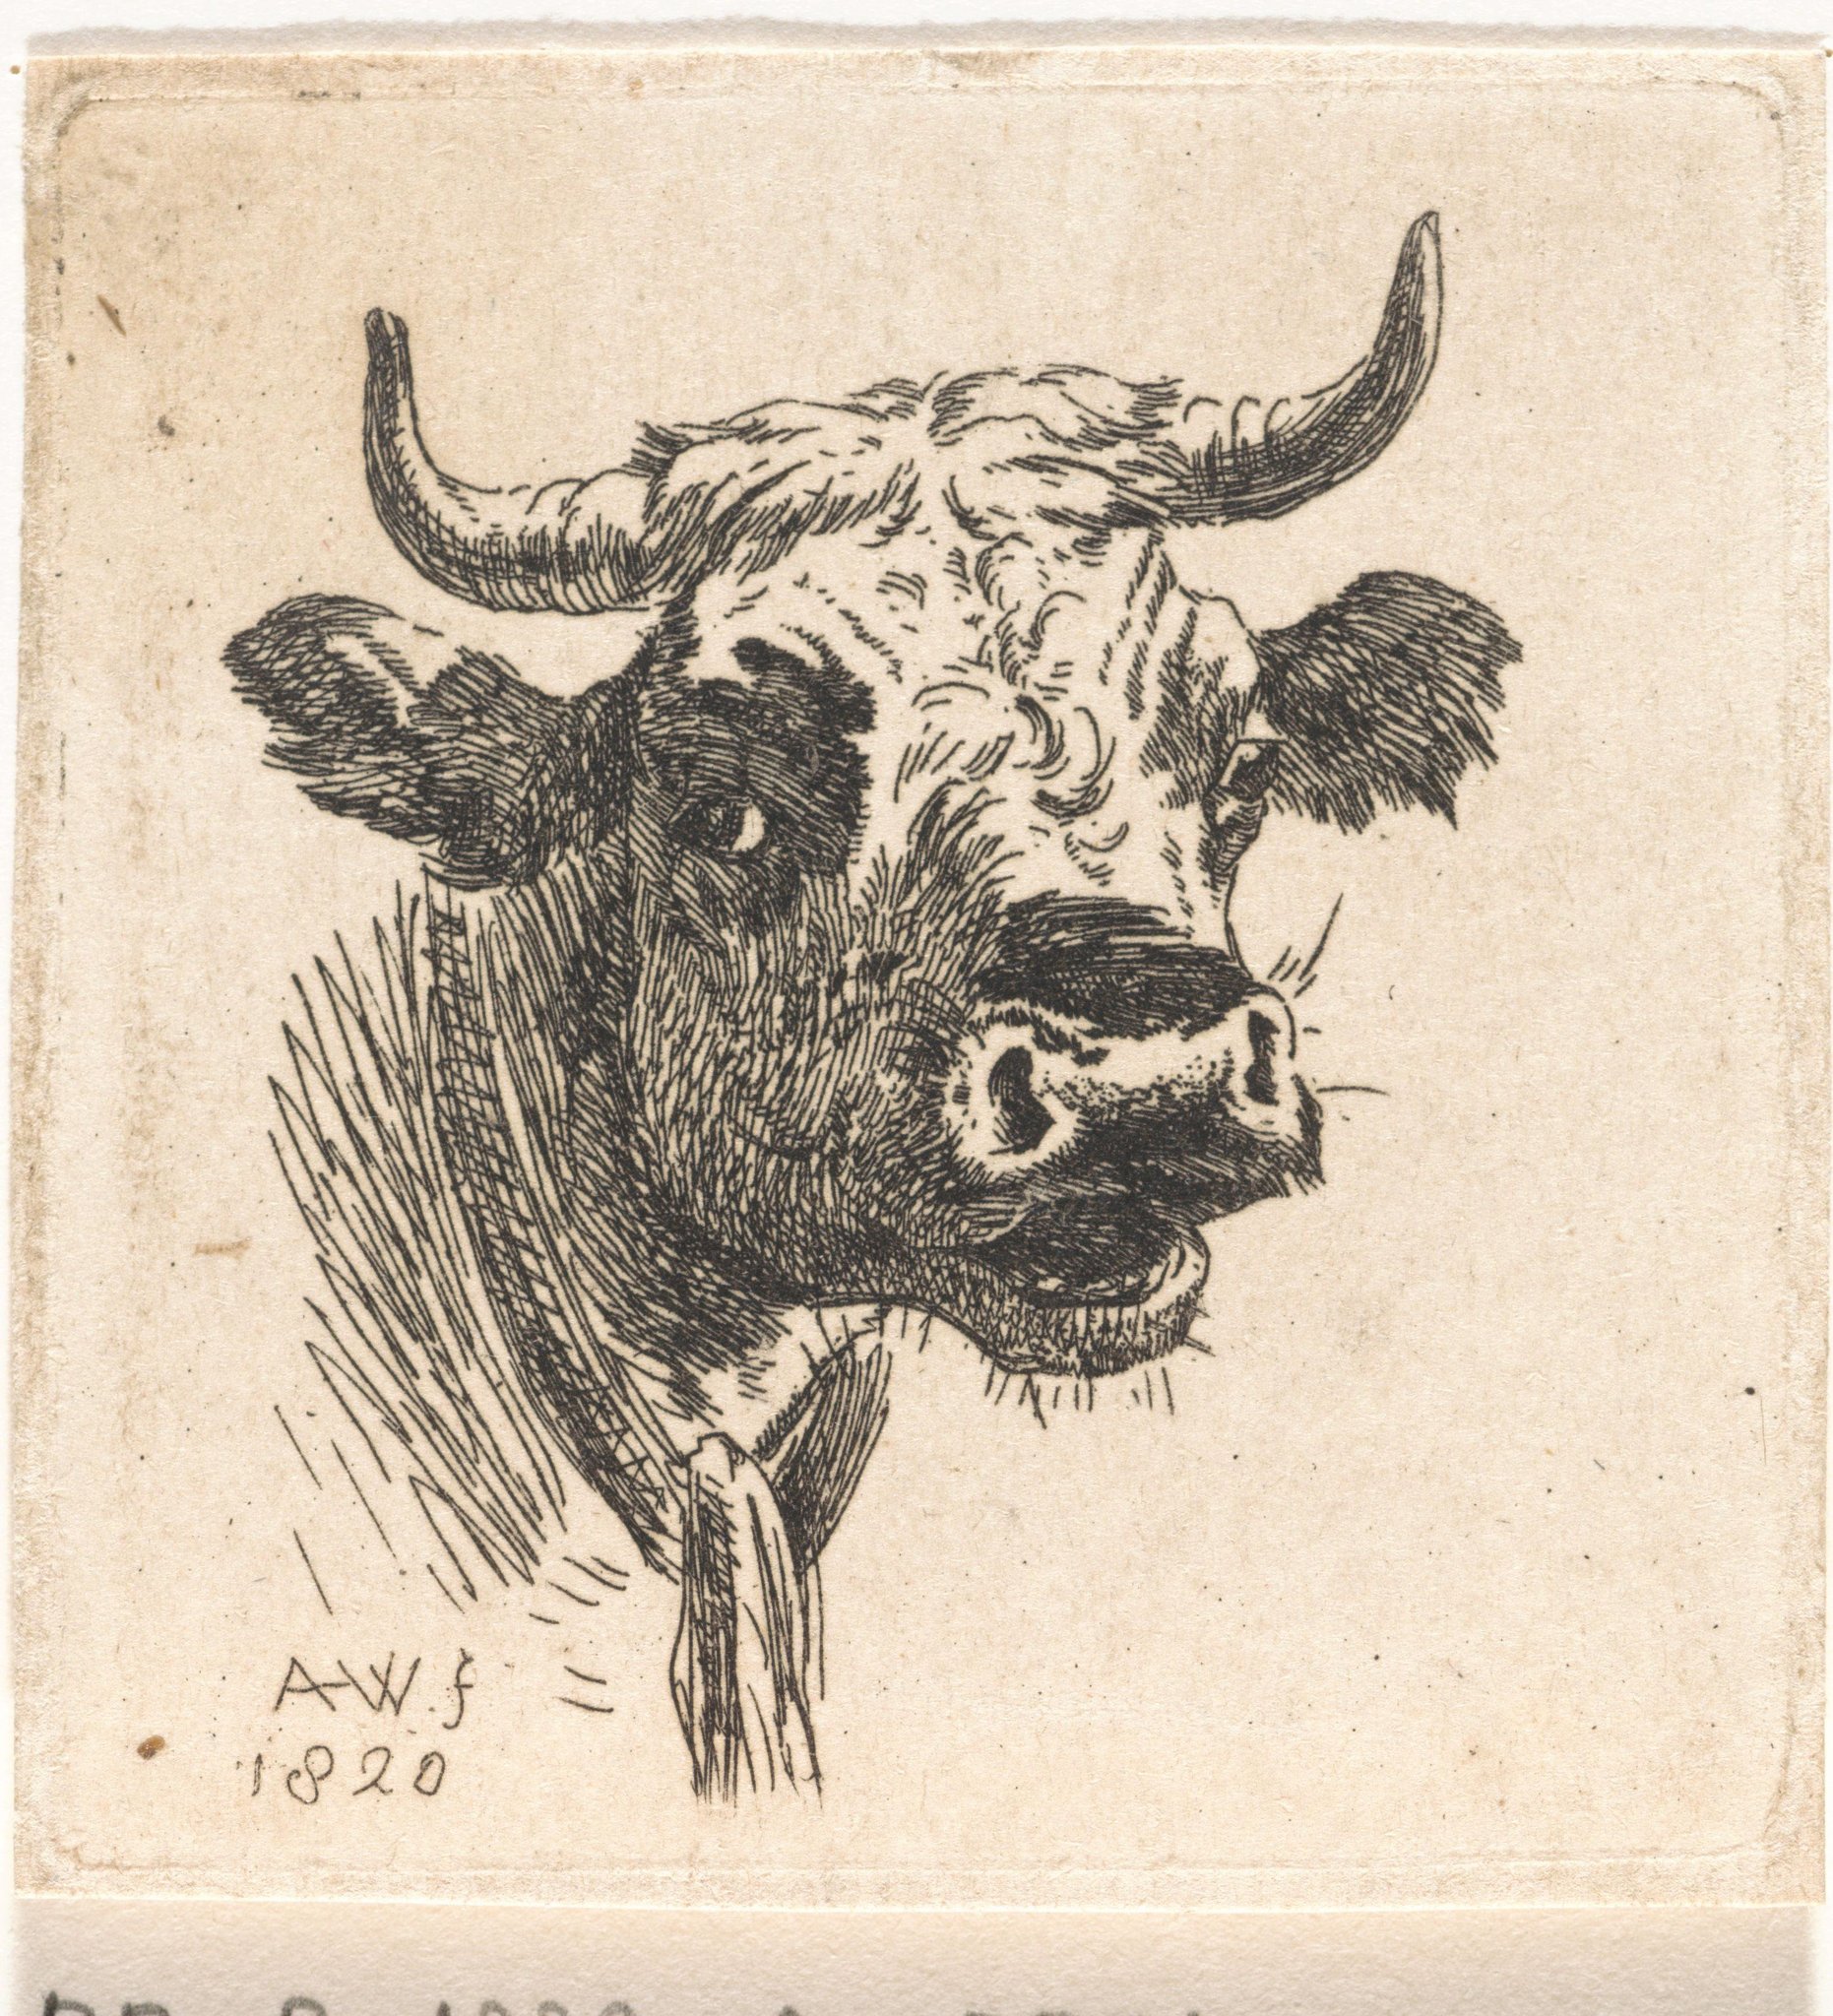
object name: print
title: Koeienkop, van voren gezien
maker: abraham hendrik winter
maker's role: painter, print maker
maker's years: 1800-1861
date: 1820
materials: paper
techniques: etching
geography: utrecht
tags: cow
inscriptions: collector's mark: Lugt 2228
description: Koeienkop met een half geopende bek, van voren gezien. Om haar nek hangt een touw.